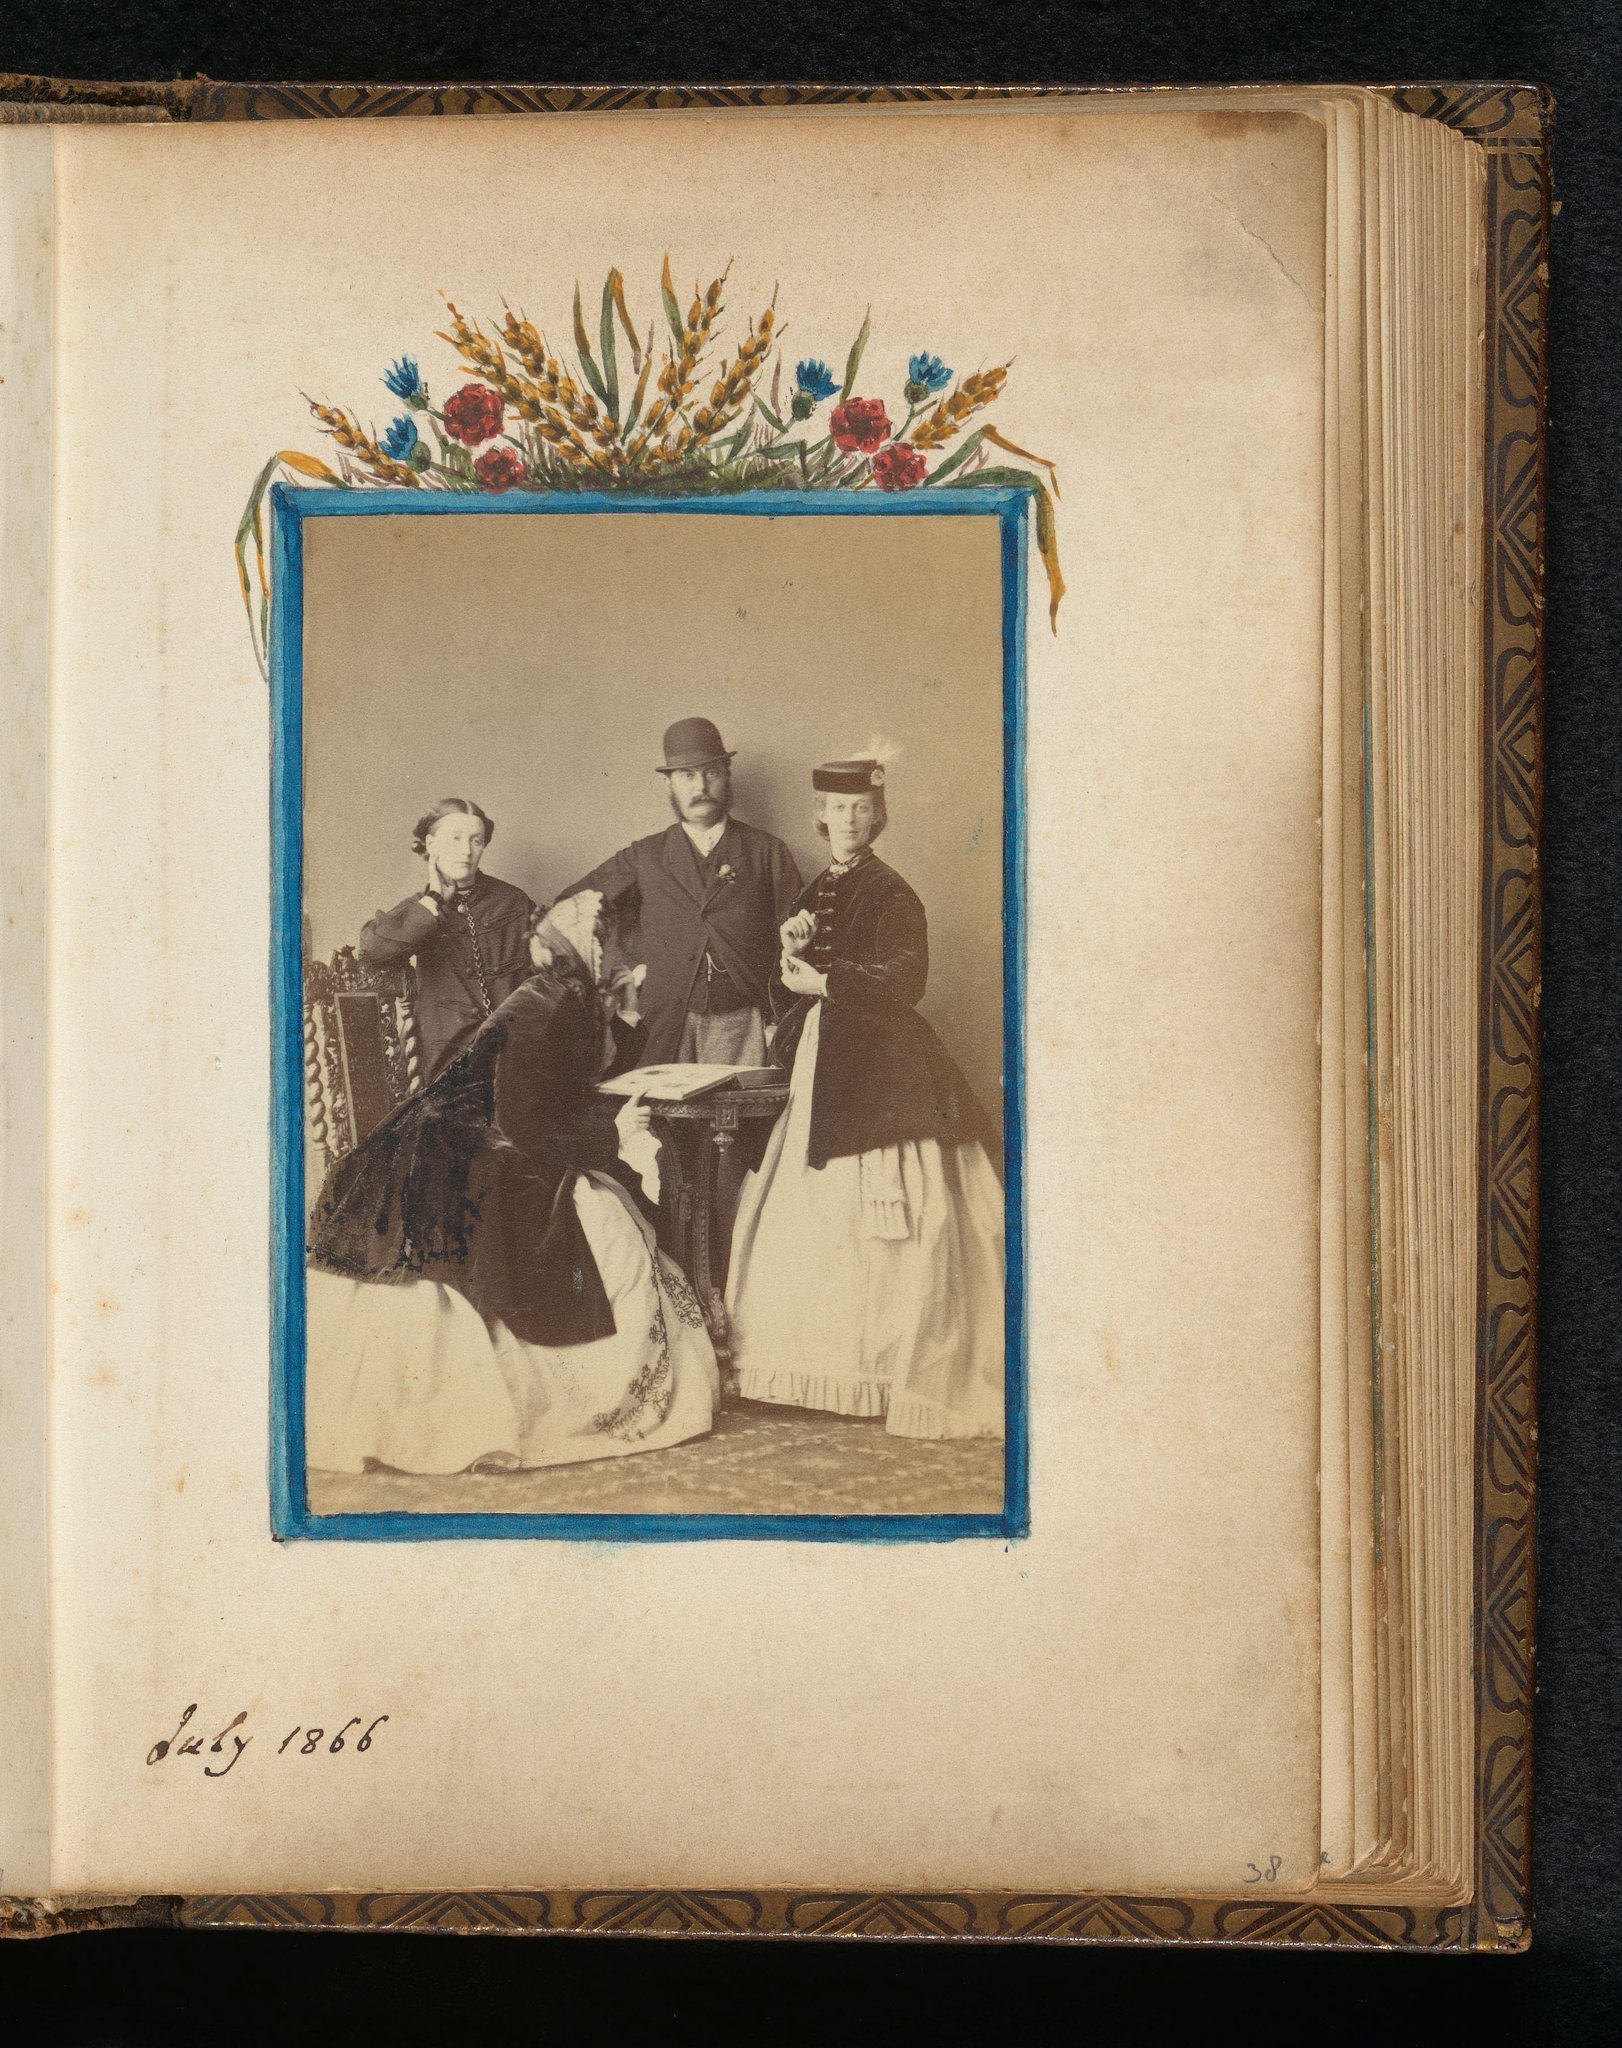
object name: photograph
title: Groepsportret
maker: Anonymous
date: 1807-1866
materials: cardboard, photographic support, watercolor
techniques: albumen print, aquarelle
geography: england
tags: historical persons not known by name - bb - woman, historical persons not known by name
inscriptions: date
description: Groepsportret met een man en drie vrouwen. Foto op albumblad in album met 68 foto's merendeels met geaquarelleerde randversieringen. Het zijn voornamelijk portretten op carte-de-visite formaat.